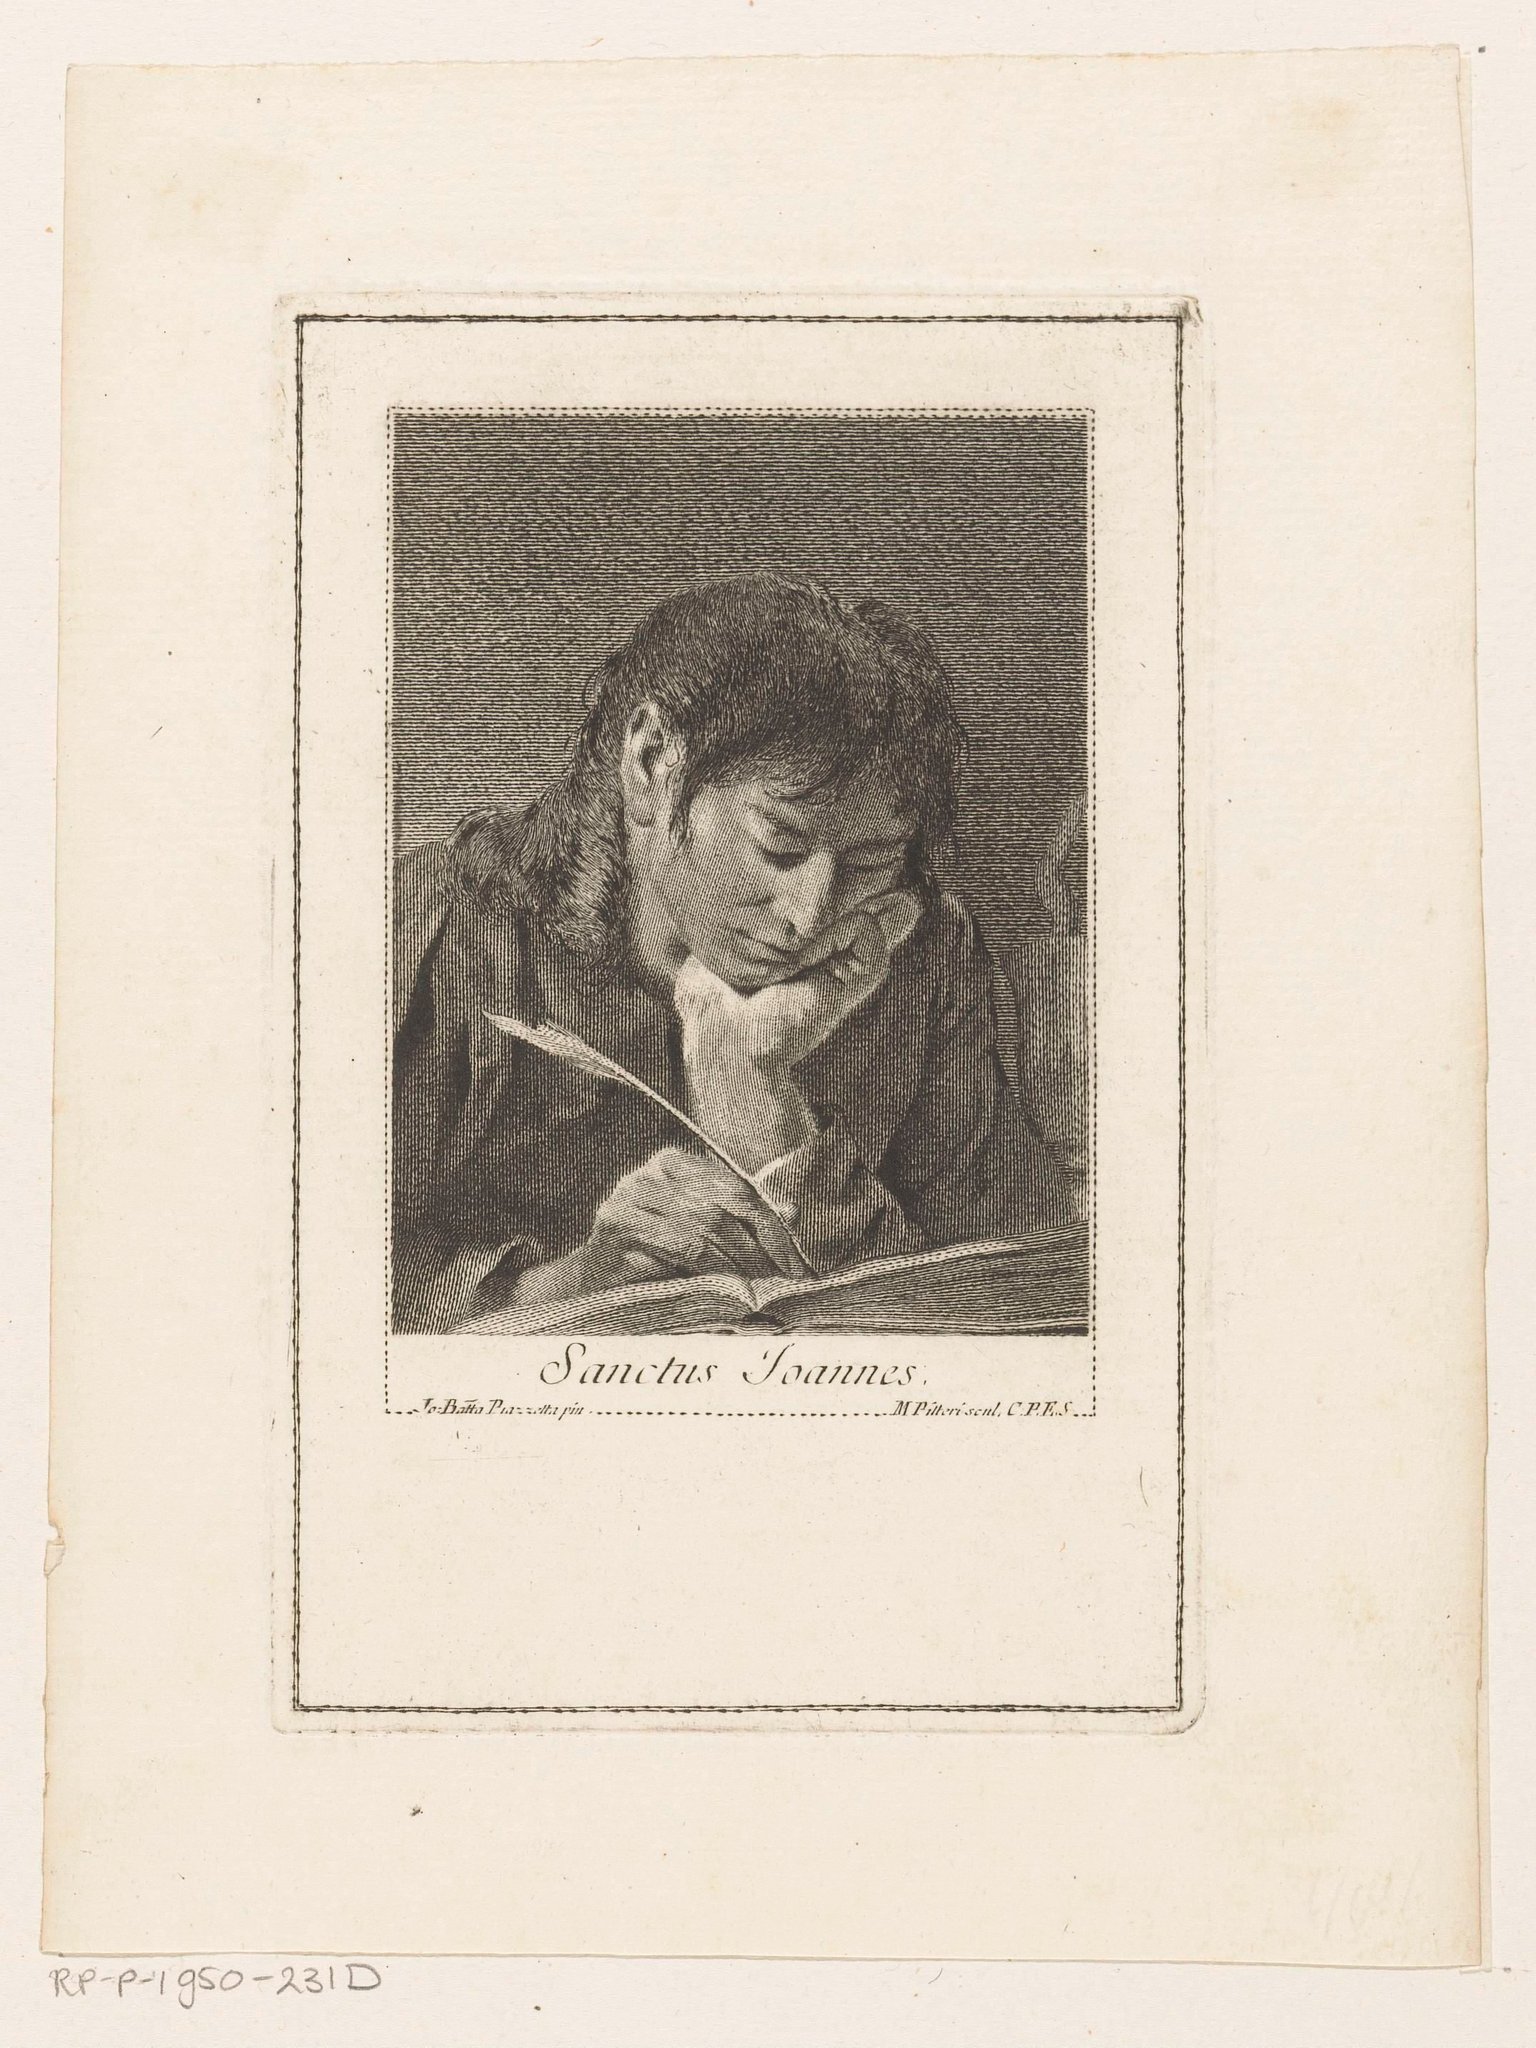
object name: print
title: Sanctus Joannes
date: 1712-1786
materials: paper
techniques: engraving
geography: venice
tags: the apostle john the evangelist; possible attributes: book, cauldron, chalice with snake, eagle, palm, scroll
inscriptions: collector's mark: Lugt 2228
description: In de literatuur worden alleen de twaalf apostelen samen als serie geteld. Maar uit de collectie van het Rijksmuseum kunnen we opmaken dat de serie uit ten minste 19 prenten en een titelprent bestond.